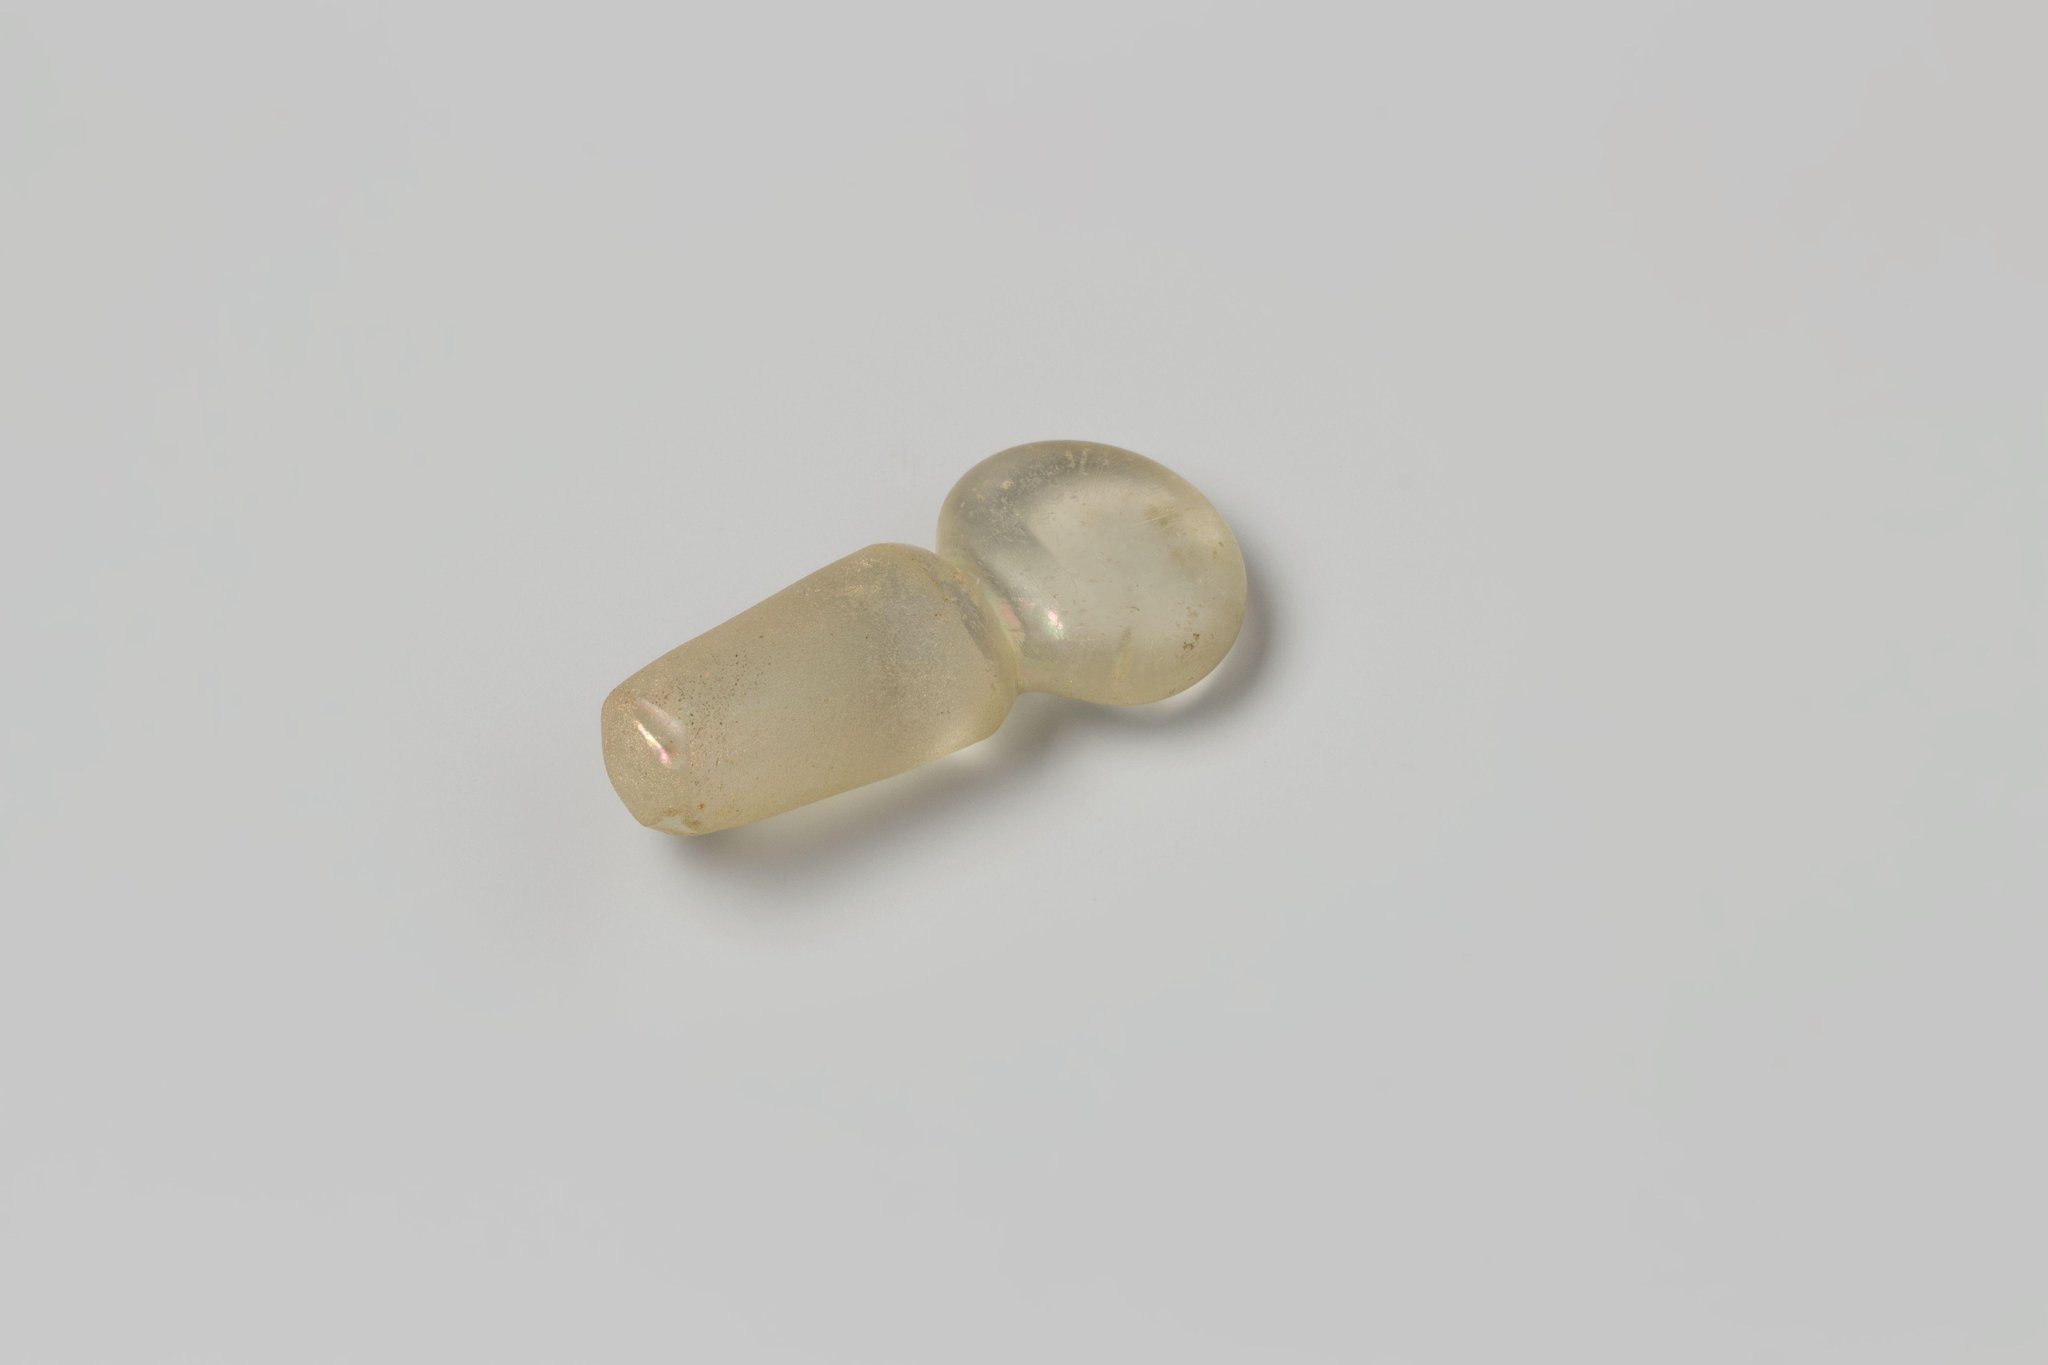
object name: vessel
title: Stop van vaatwerk uit het wrak van de Oost-Indiëvaarder Hollandia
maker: Anonymous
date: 1700-1743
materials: glass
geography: netherlands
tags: verenigde oostindische compagnie, hollandia (schip), annet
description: Vessel part, stopper; tapering cylinder with plain disc-shaped finial.